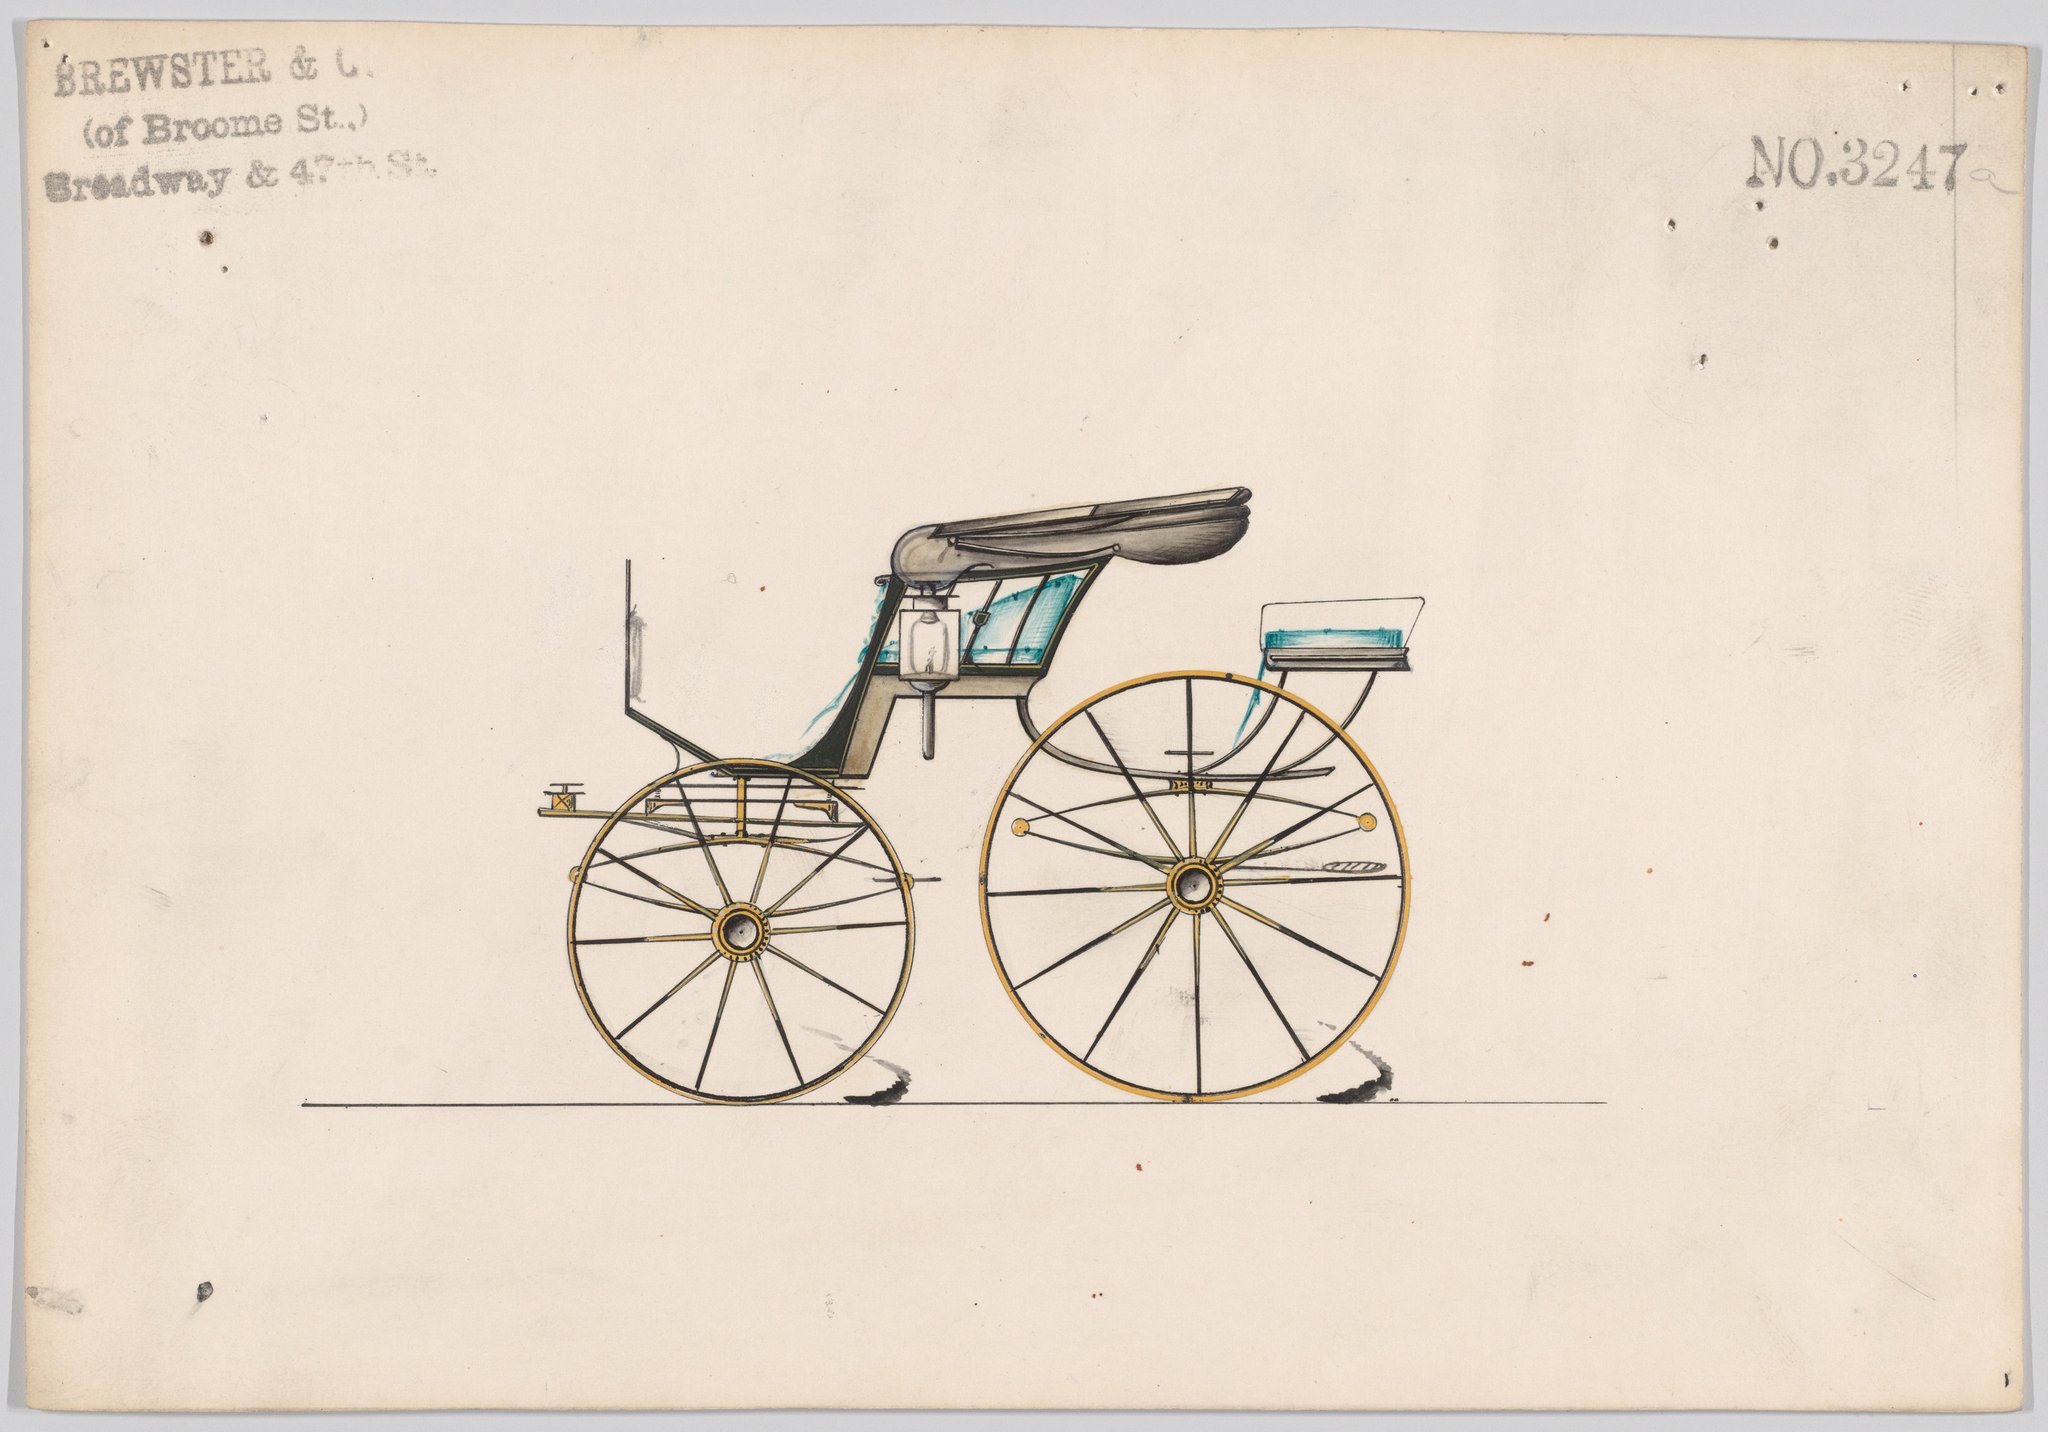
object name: drawing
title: Design for Pony Phaeton, no. 3247a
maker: brewster & co.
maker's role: manufacturer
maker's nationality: american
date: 1876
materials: gouache, ink, watercolor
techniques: pen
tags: carriages